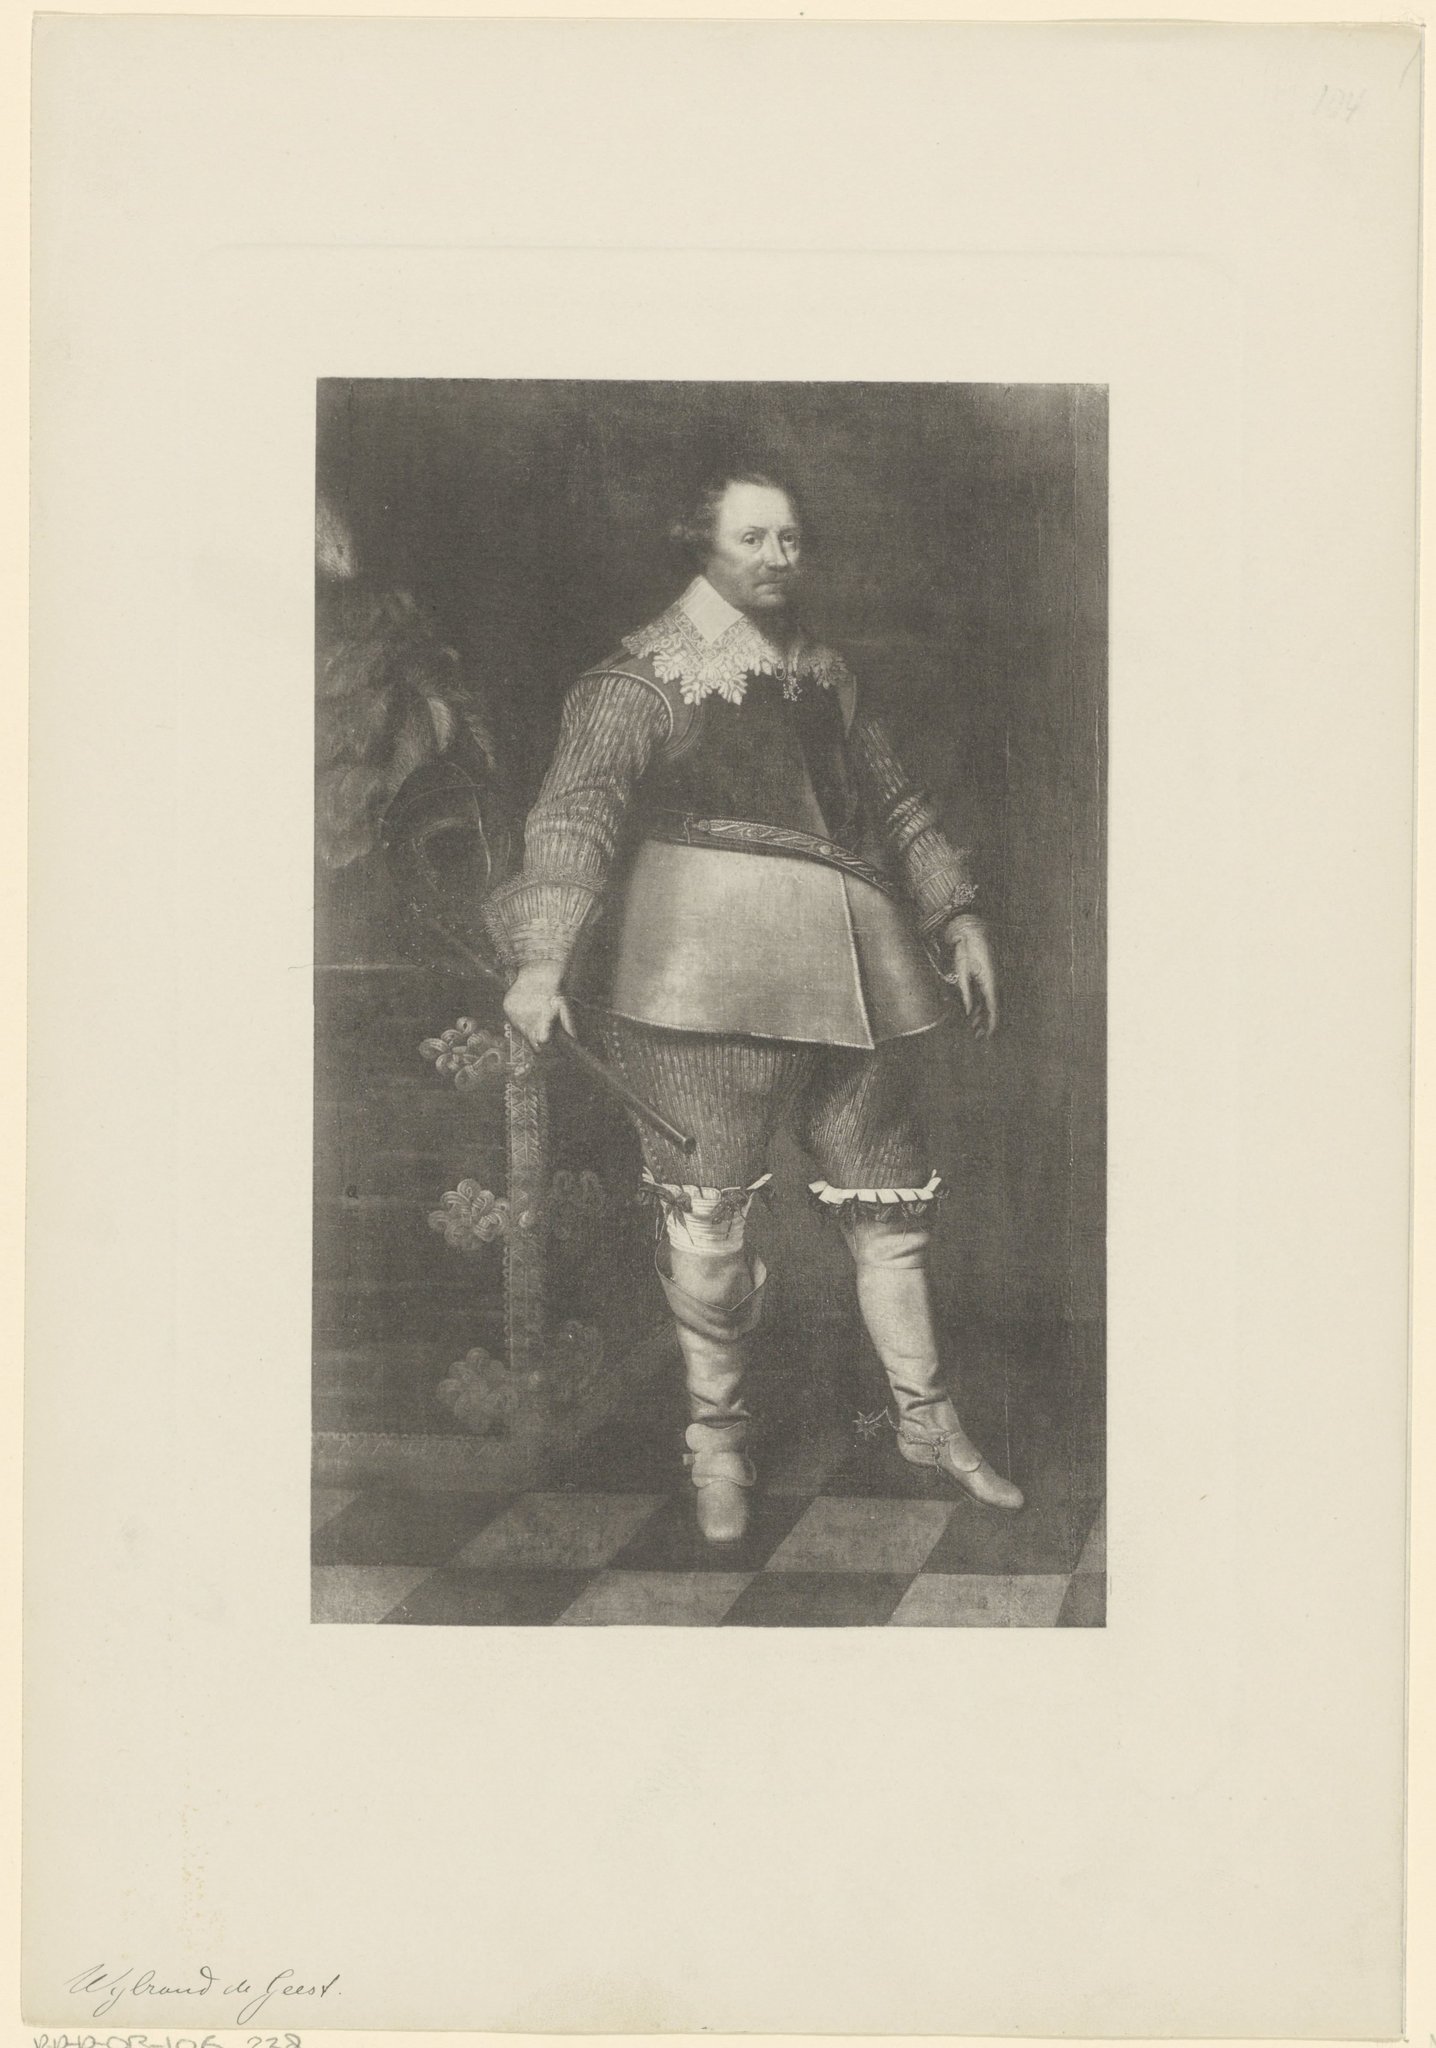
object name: photomechanical print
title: Portret van Ernst Casimir, graaf van Nassau-Dietz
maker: Anonymous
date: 1850-1949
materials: paper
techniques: photograph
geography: netherlands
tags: ernst casimir graaf van nassau-dietz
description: De hier vermelde titel verwijst naar de hoogst verkregen titel van de geportretteerde, niet per se naar de titel die de geportretteerde op deze voorstelling draagt.